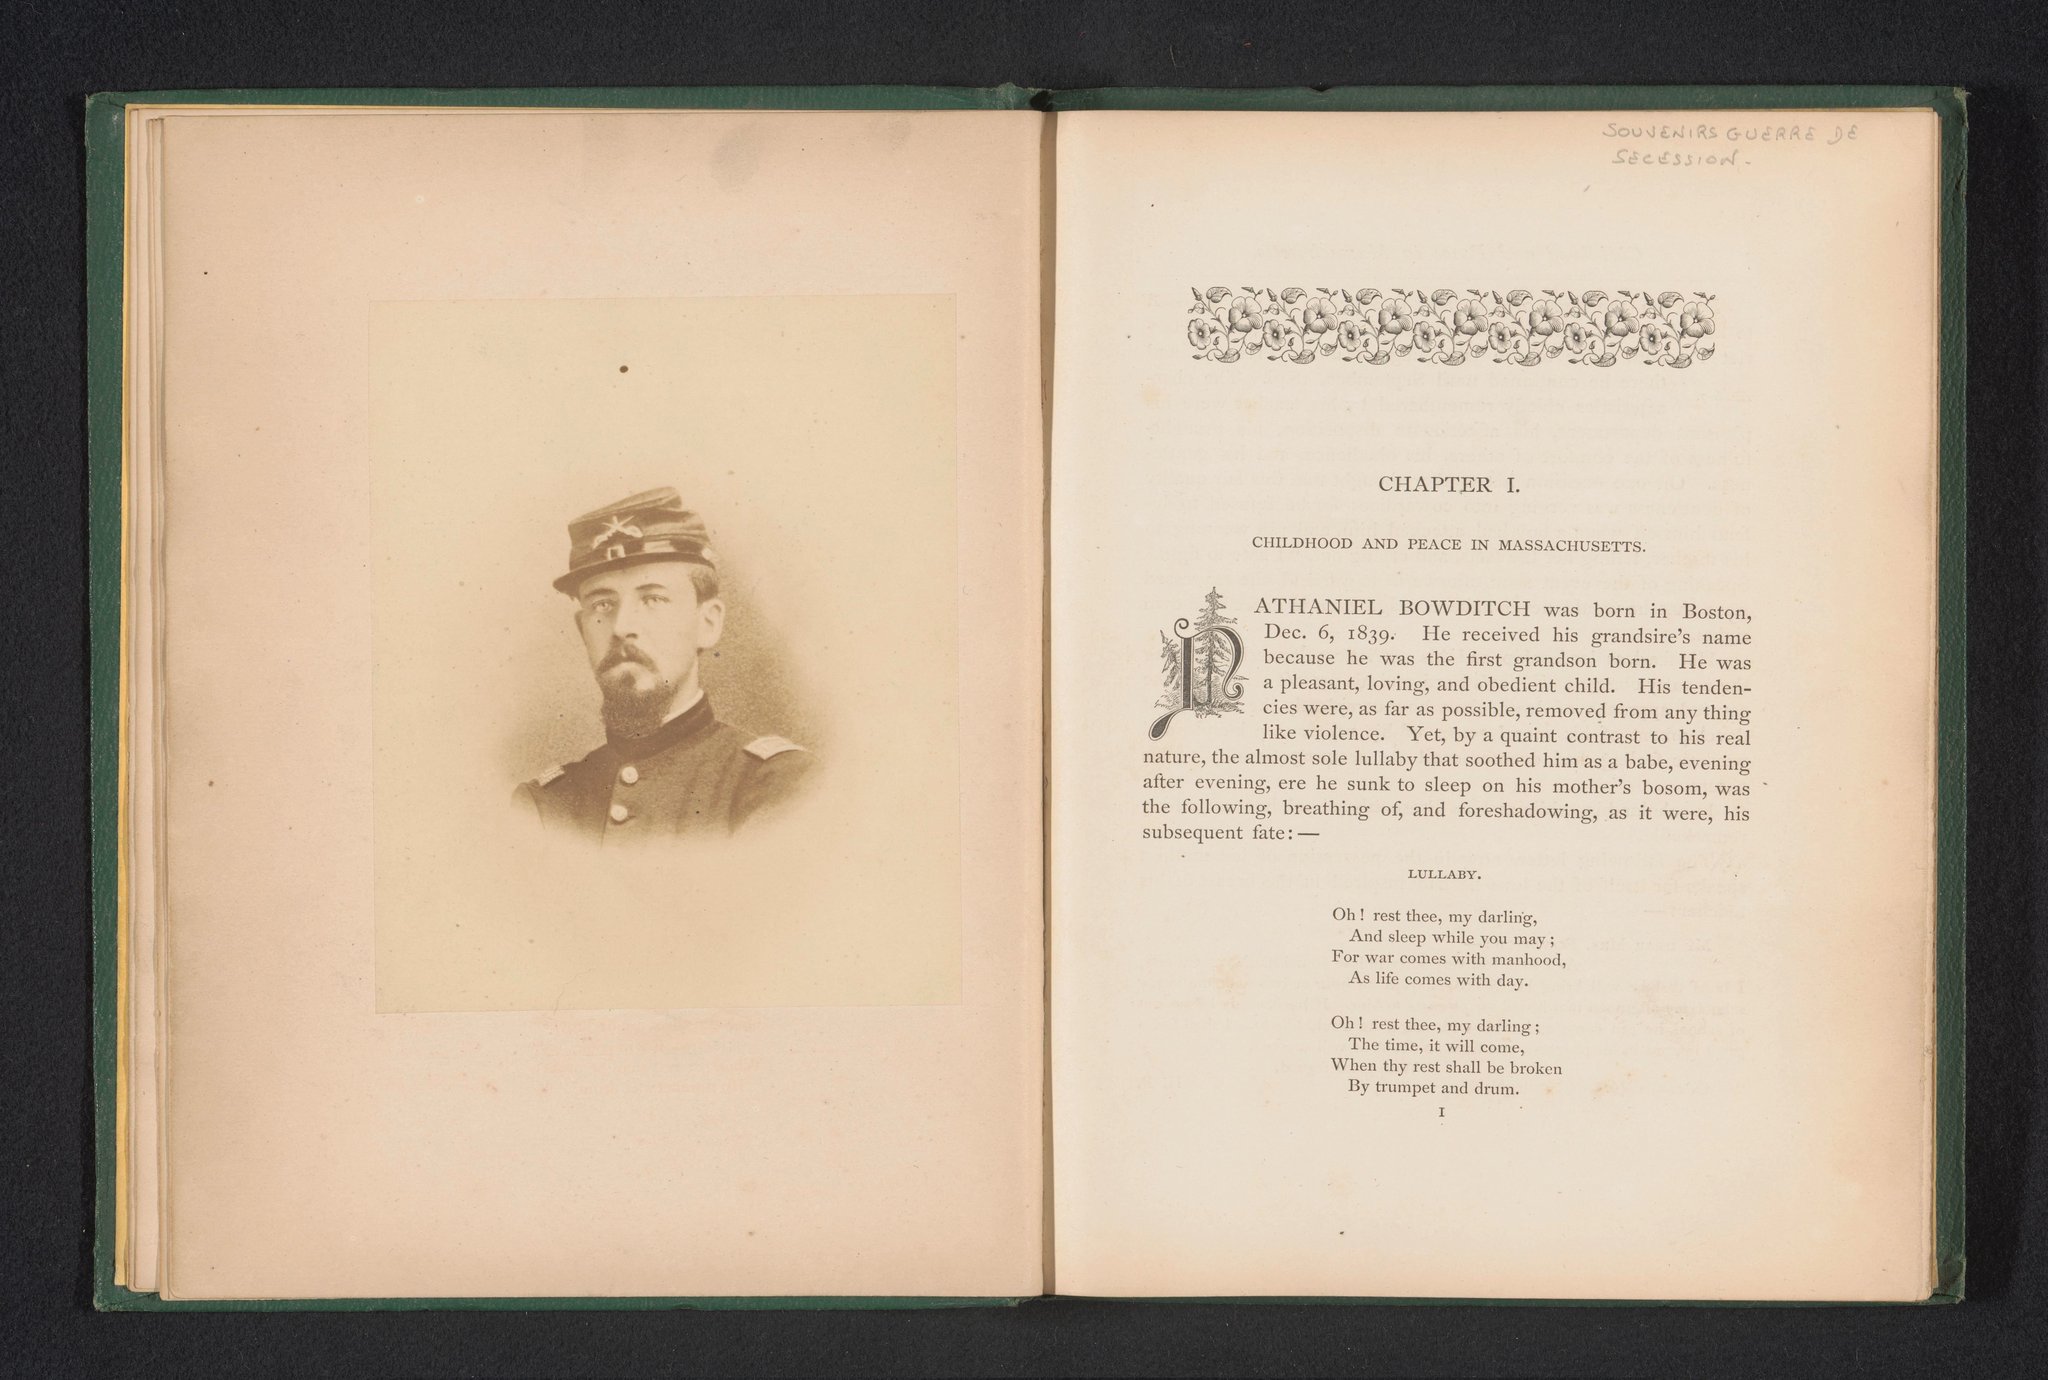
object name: photograph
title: Portret van Nathaniel Bowditch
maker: Anonymous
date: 1860-1865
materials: photographic support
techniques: albumen print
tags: adult man, historical persons